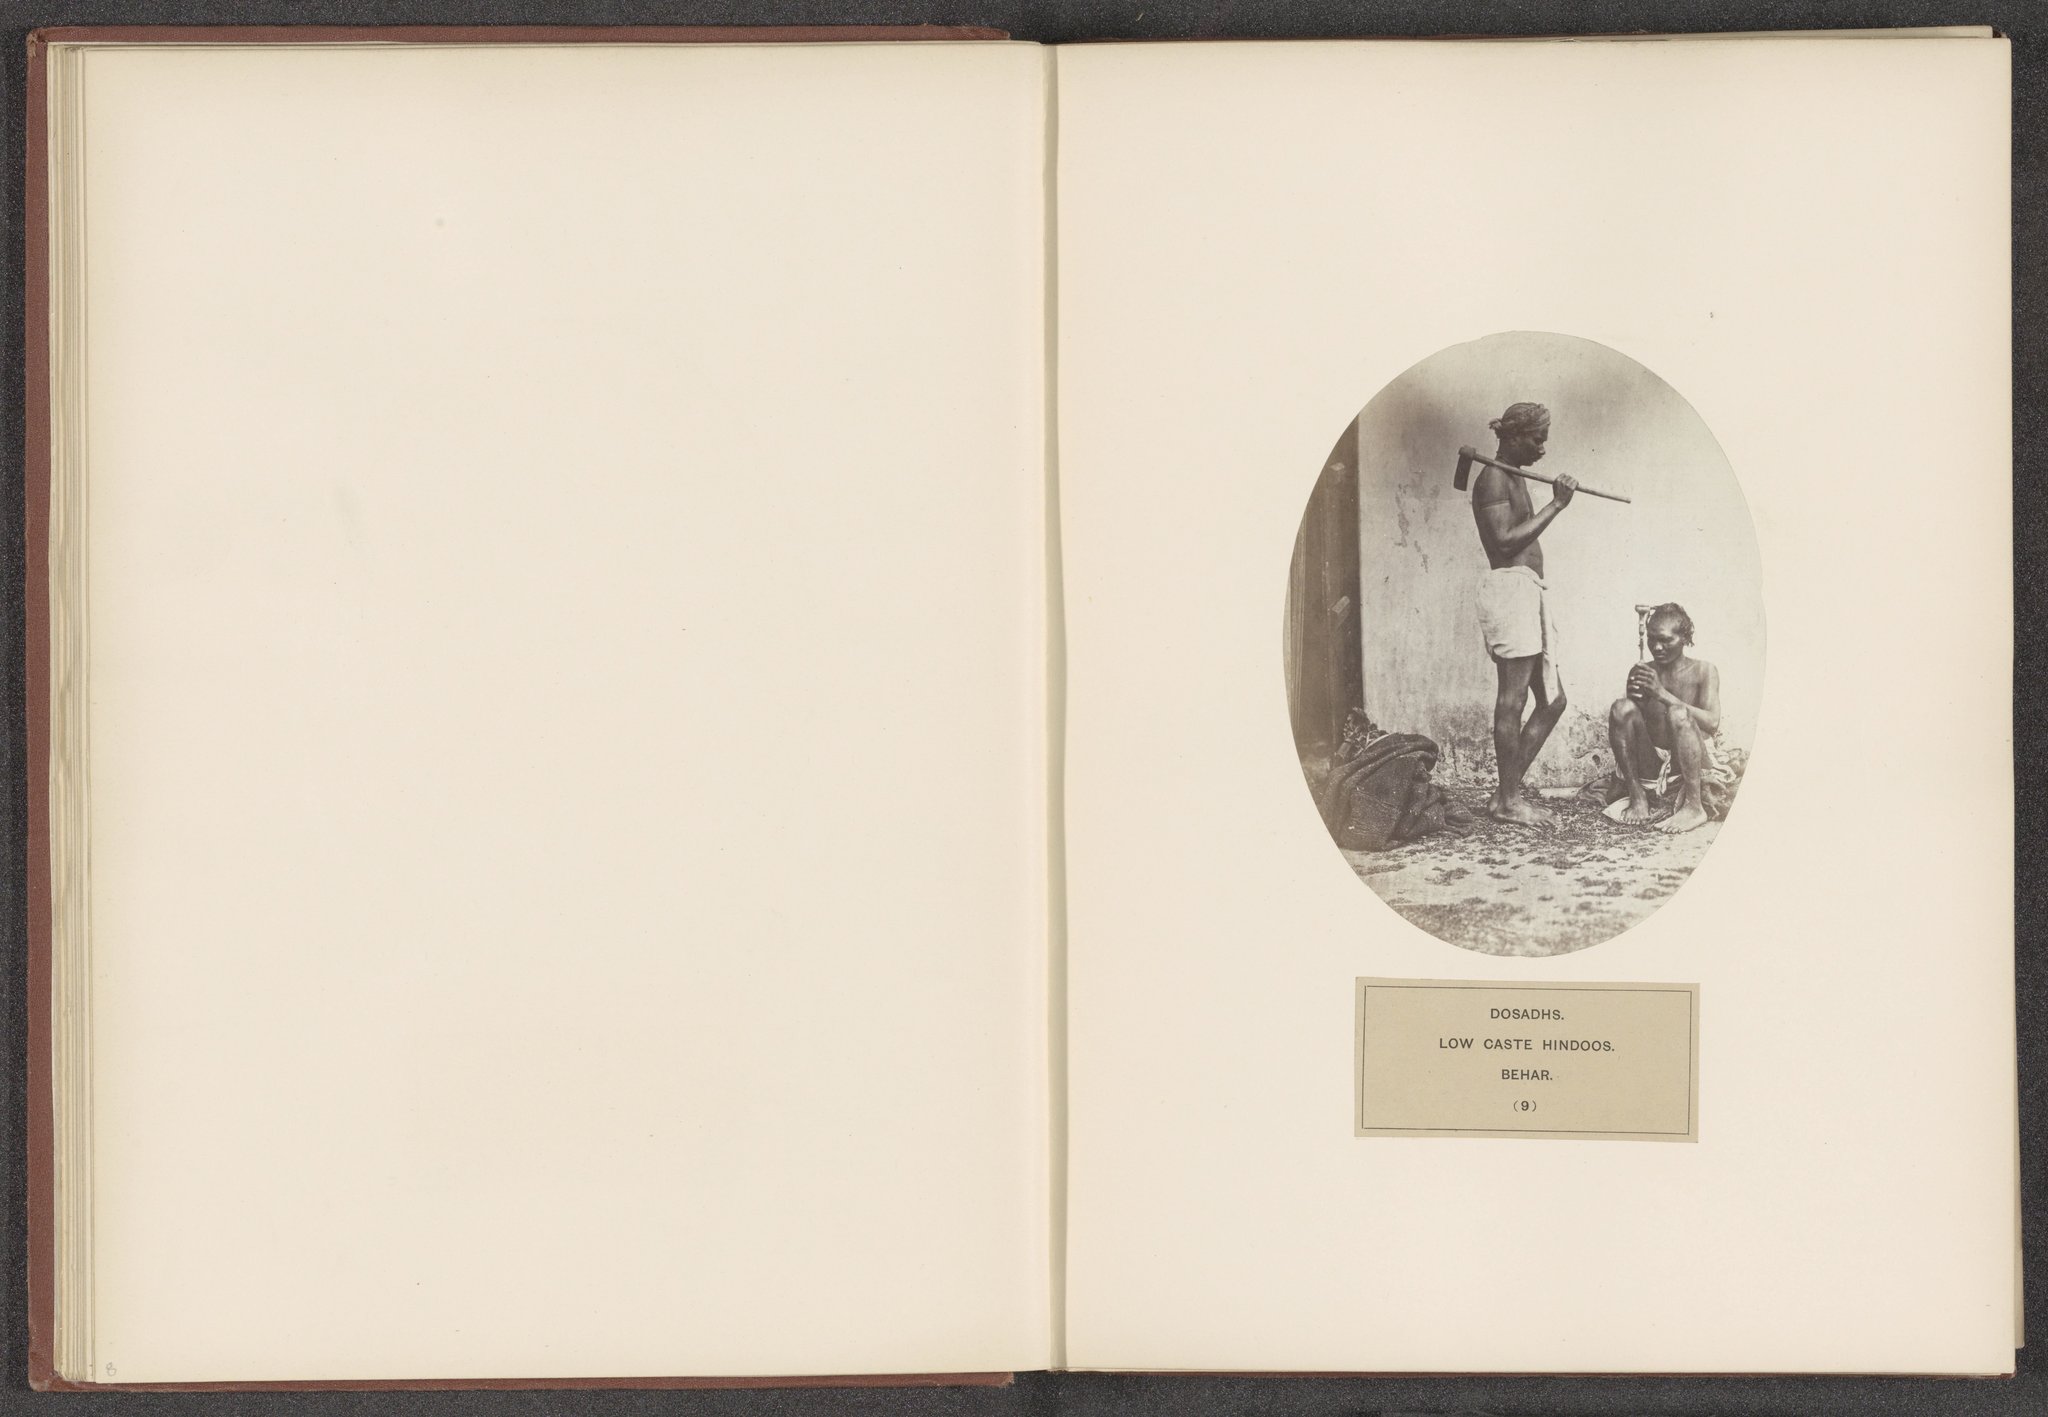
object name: page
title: Two unknown men with tools from the Dusadh community of Bihar in eastern India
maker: Anonymous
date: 1858-1868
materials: photographic support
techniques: albumen print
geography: bihar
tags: human races; peoples; nationalities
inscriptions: number: ‘(9)’, inscription: ‘DOSADHS./ LOW CASTE HINDOOS./ BEHAR.’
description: De Dusadh-gemeenschap is ook bekend als Paswan.